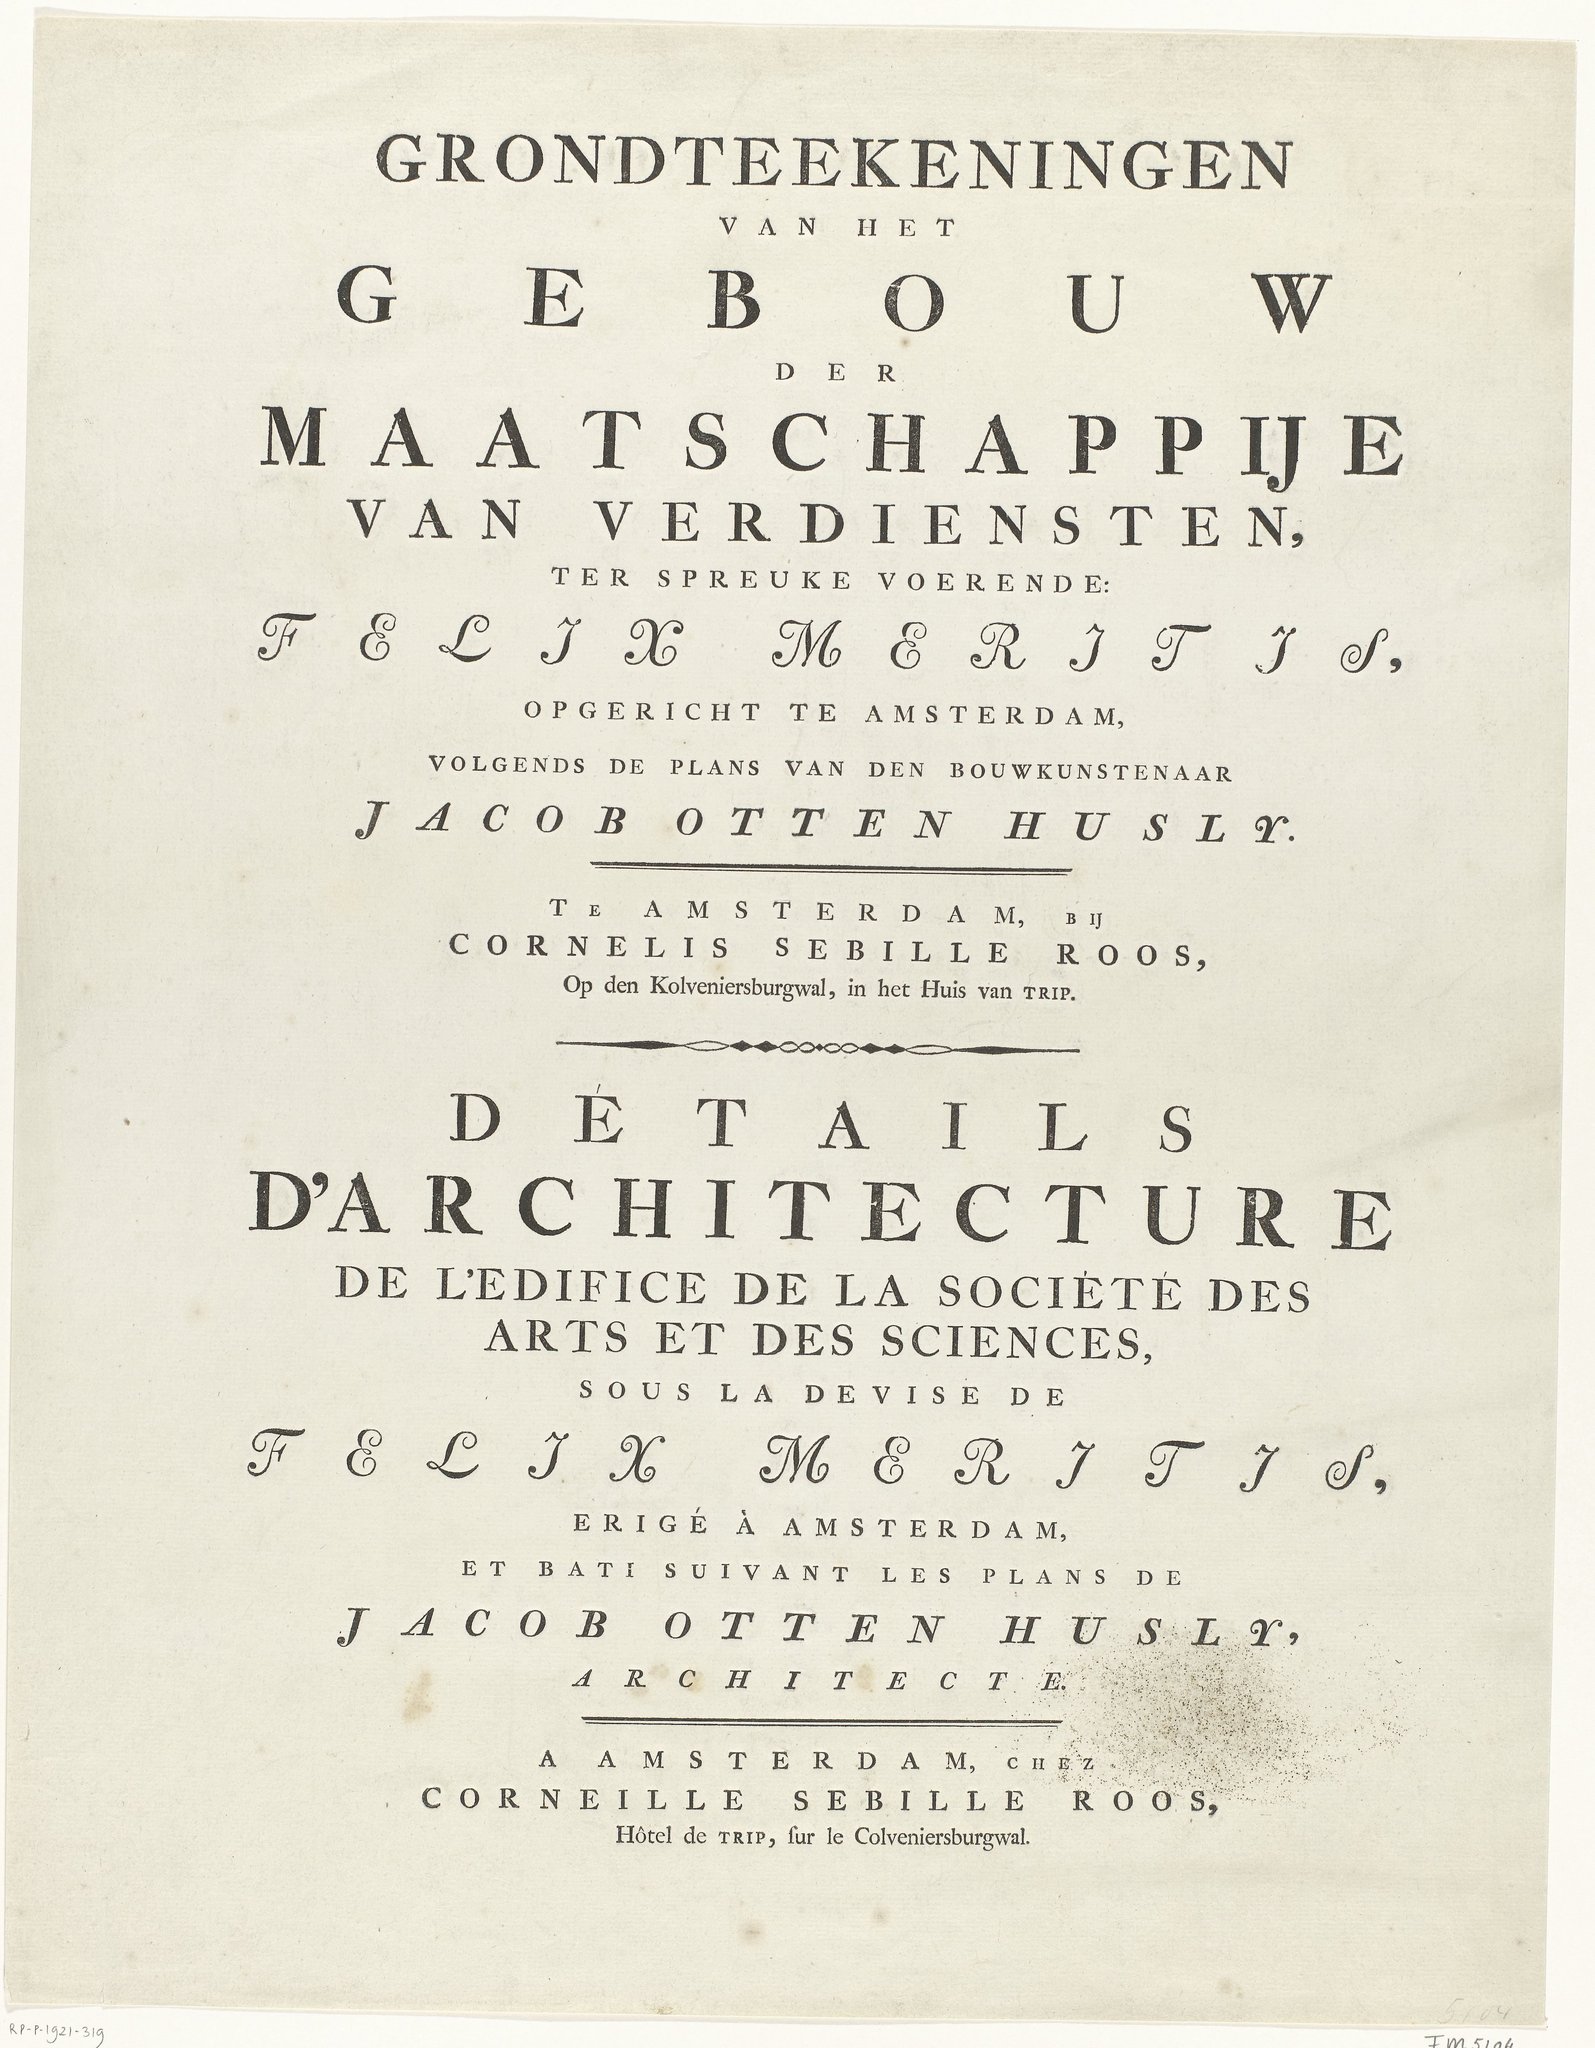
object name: titelblad, titelpagina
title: Grondteekeningen van het Gebouw der Maatschappije van Verdiensten, ter spreuke voerende: Felix Meritis (...) / Détails d'architecture de l'edifice de la Société des Arts et des Sciences, sous la devise de Felix Meritis (...)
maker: cornelis sebille roos (uitgever)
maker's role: auctioneer, draughtsman, publisher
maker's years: 1754-1820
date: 1789-1791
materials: paper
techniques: letterpress printing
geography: amsterdam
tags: draughtsman, jacob otten huslij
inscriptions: collector's mark: Lugt 2233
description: Titelpagina van het plaatwerk over de architectuur van het gebouw voor de maatschappij Felix Meritis te Amsterdam, ontworpen door de achitect Jacob Otten Huslij en ingewijd op 31 oktober 1788. Tekstblad met de twee titels in het Nederlands en Frans.